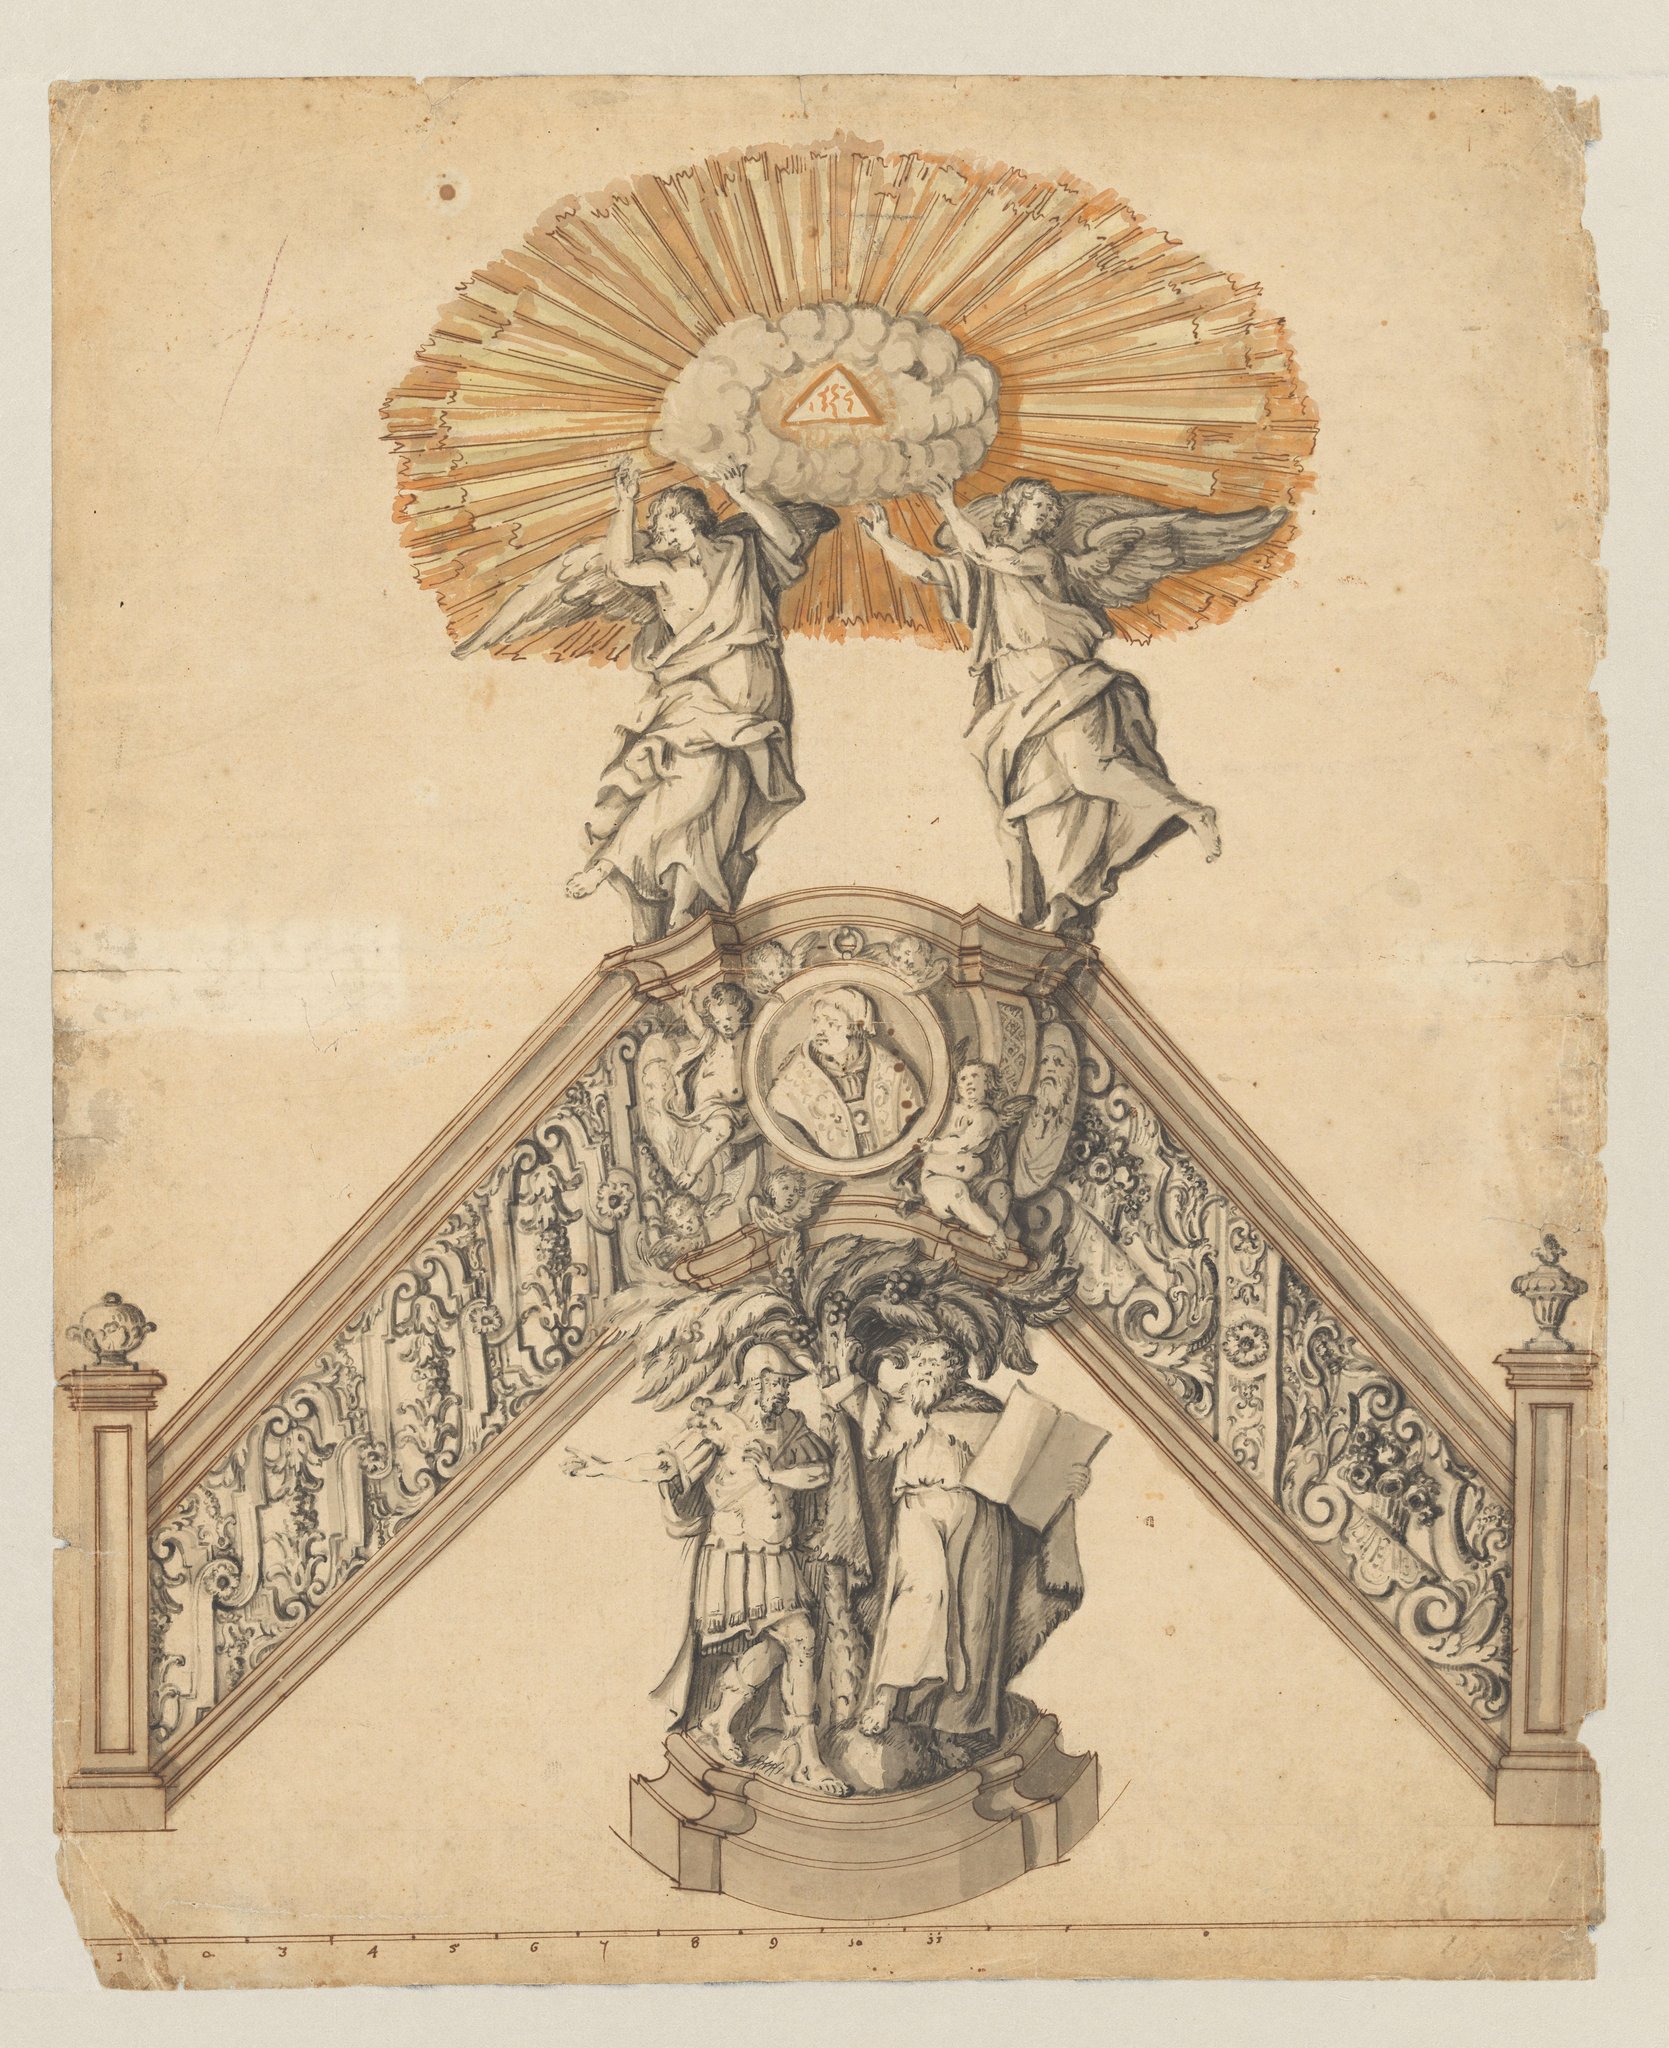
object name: design drawing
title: Ontwerp voor een preekstoel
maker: willem ignatius kerricx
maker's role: sculptor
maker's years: 1682-1745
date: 1700-1725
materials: ink, paper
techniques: brush, pen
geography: antwerp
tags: pulpit, ambo, chancel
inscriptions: monogram: ‘C.P.’, watermark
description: Onder een maatverdeling met 1 2 3 4 5 6 7 8 9 10 11; in verso een (later) opschrift in grafiet: ne pas faire. Op het recente passe-partout het opschrift: Projet pour l'eglise St Augustin à ANVERS / - H F. VERBRUGGHEN - 1654-1724 -.